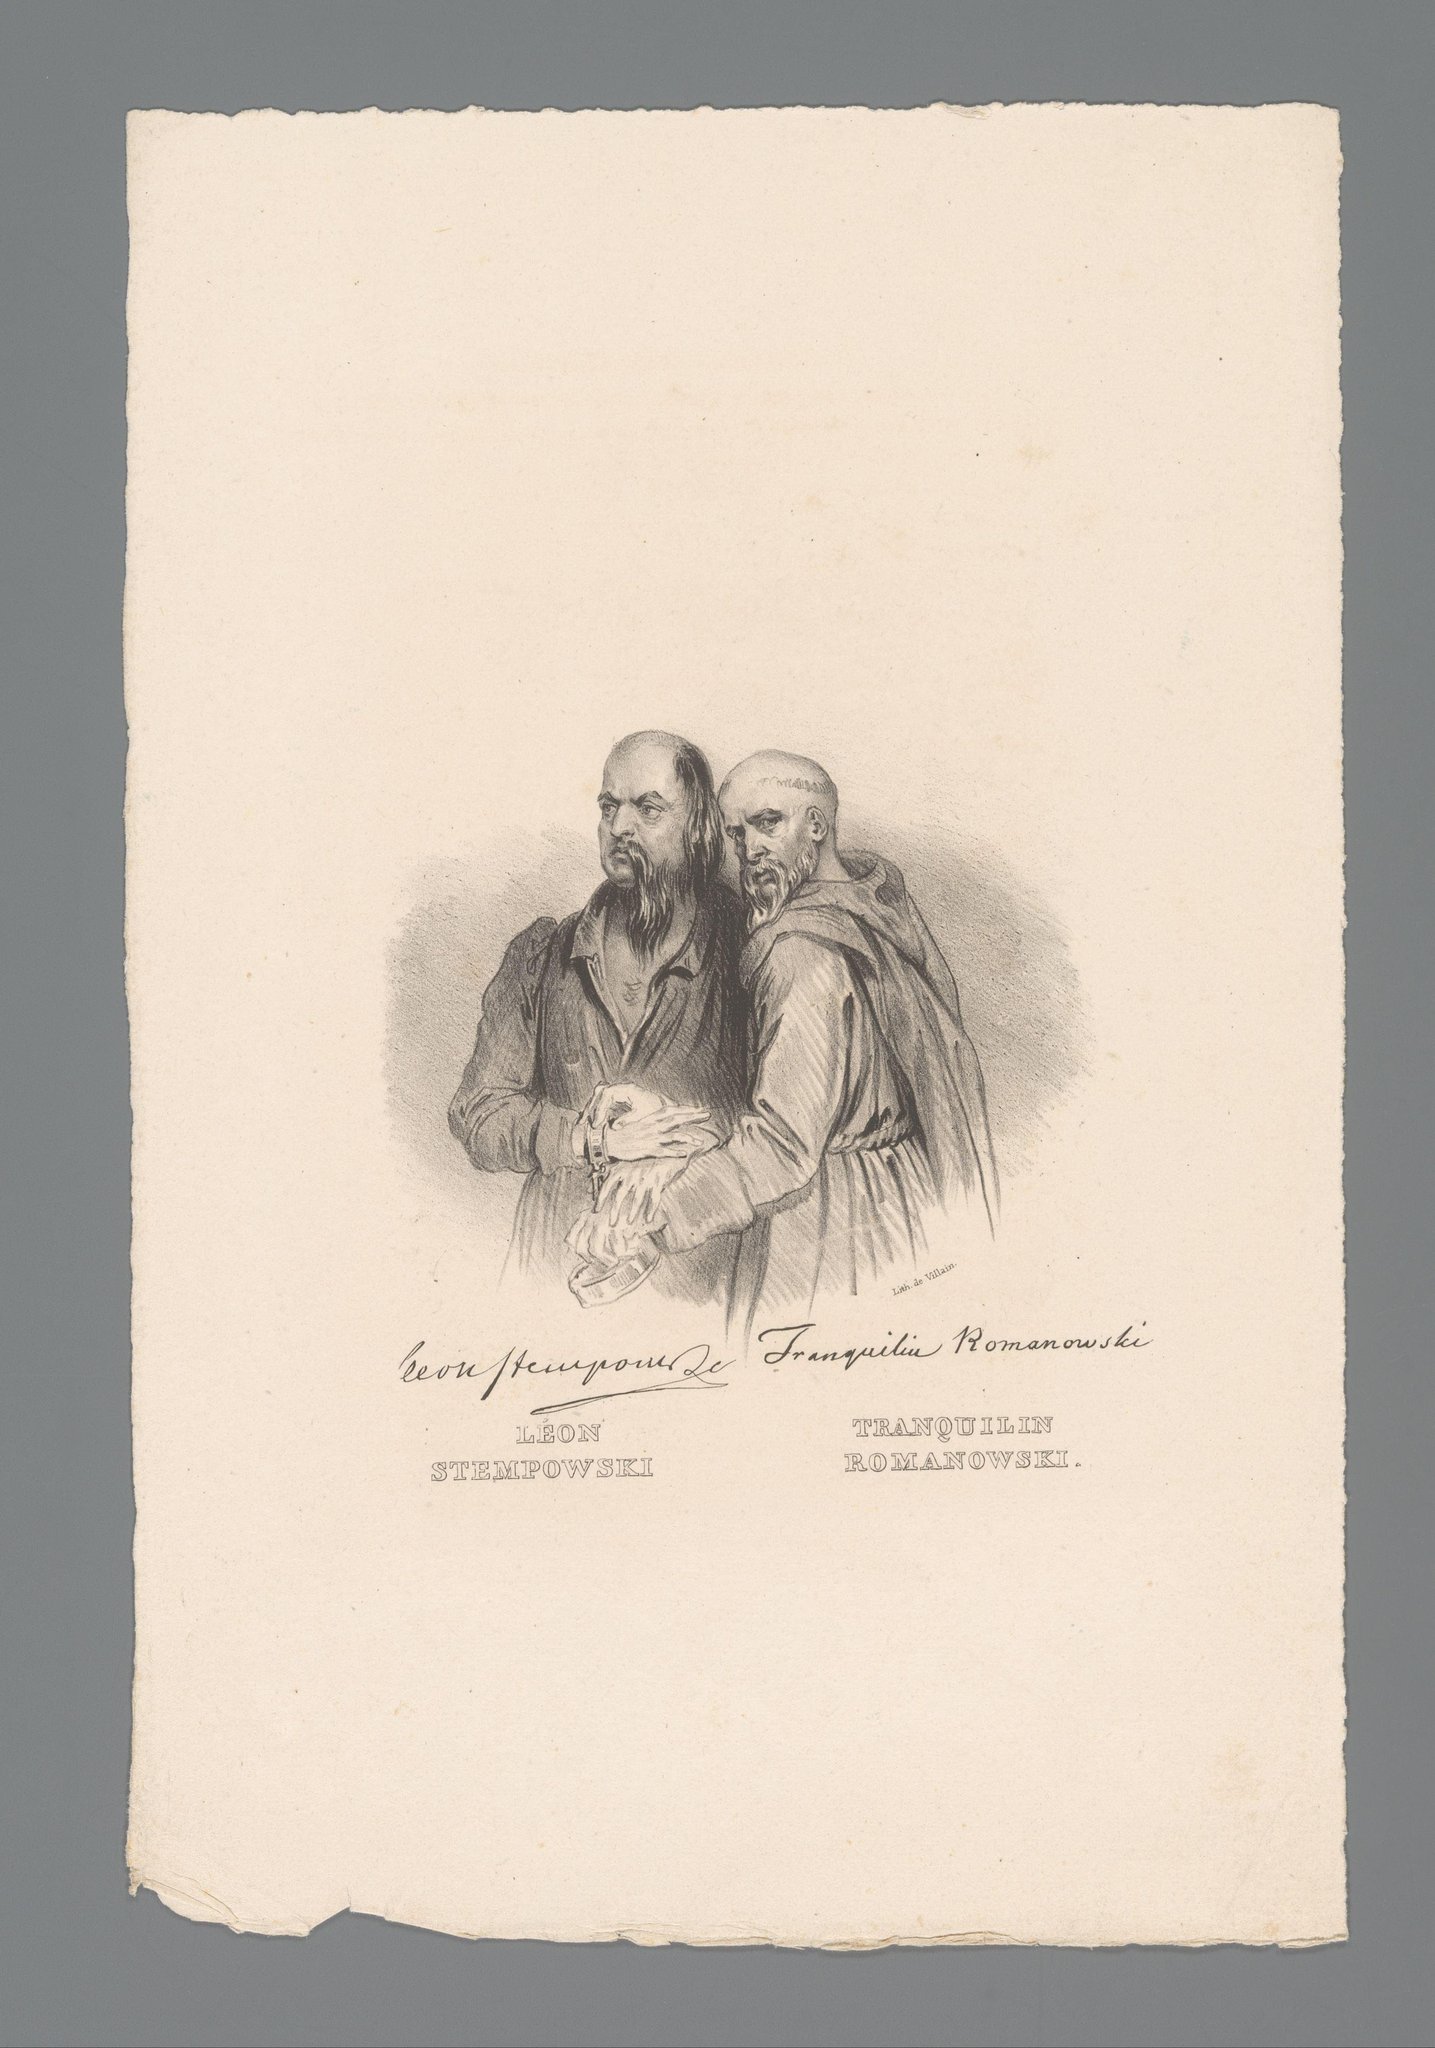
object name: print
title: Léon Stempowski, Tranquilin Romanowski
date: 1832-1839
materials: paper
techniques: lithograph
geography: paris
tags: historical persons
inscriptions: collector's mark: Lugt 2228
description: Prent uit: Straszewicz., Joseph. Les polonais et les polonaises de la révolution du 29 novembre 1830, ou Portraits des personnes qui ont figuré dans la dernière guerre de l'indépendance polonaise, avec les fac-simile de leur signature, lithographiés sur dessins originaux, par les artistes les plus distingués: MM. Grévedon, Maurin, Vigneron, Belliard, Devéria, Bazin, Desmadryl, Lecler, Desmaisons, Rutowski, officier polonais, etc,. etc., accompagnés d'une biographie pour chaque portrait. Parijs: Catherine-Anaïs Pinard, 1832. Of uit: Straszewicz., Joseph. Les polonais et les polonaises de la révolution du 29 novembre 1830. Biographie des personnes qui ont figuré dans la dernière guerre de l'indépendance polonaise, avec les fac-simile de leur signature, ornée de 30 portraits lithographiés sur dessins originaux, par les artistes les plus distingués: MM. Grévedon, Maurin, Vigneron, Belliard, Devéria, Bazin, Desmadryl, Lecler, etc., etc.. Parijs: s.n., 1839.